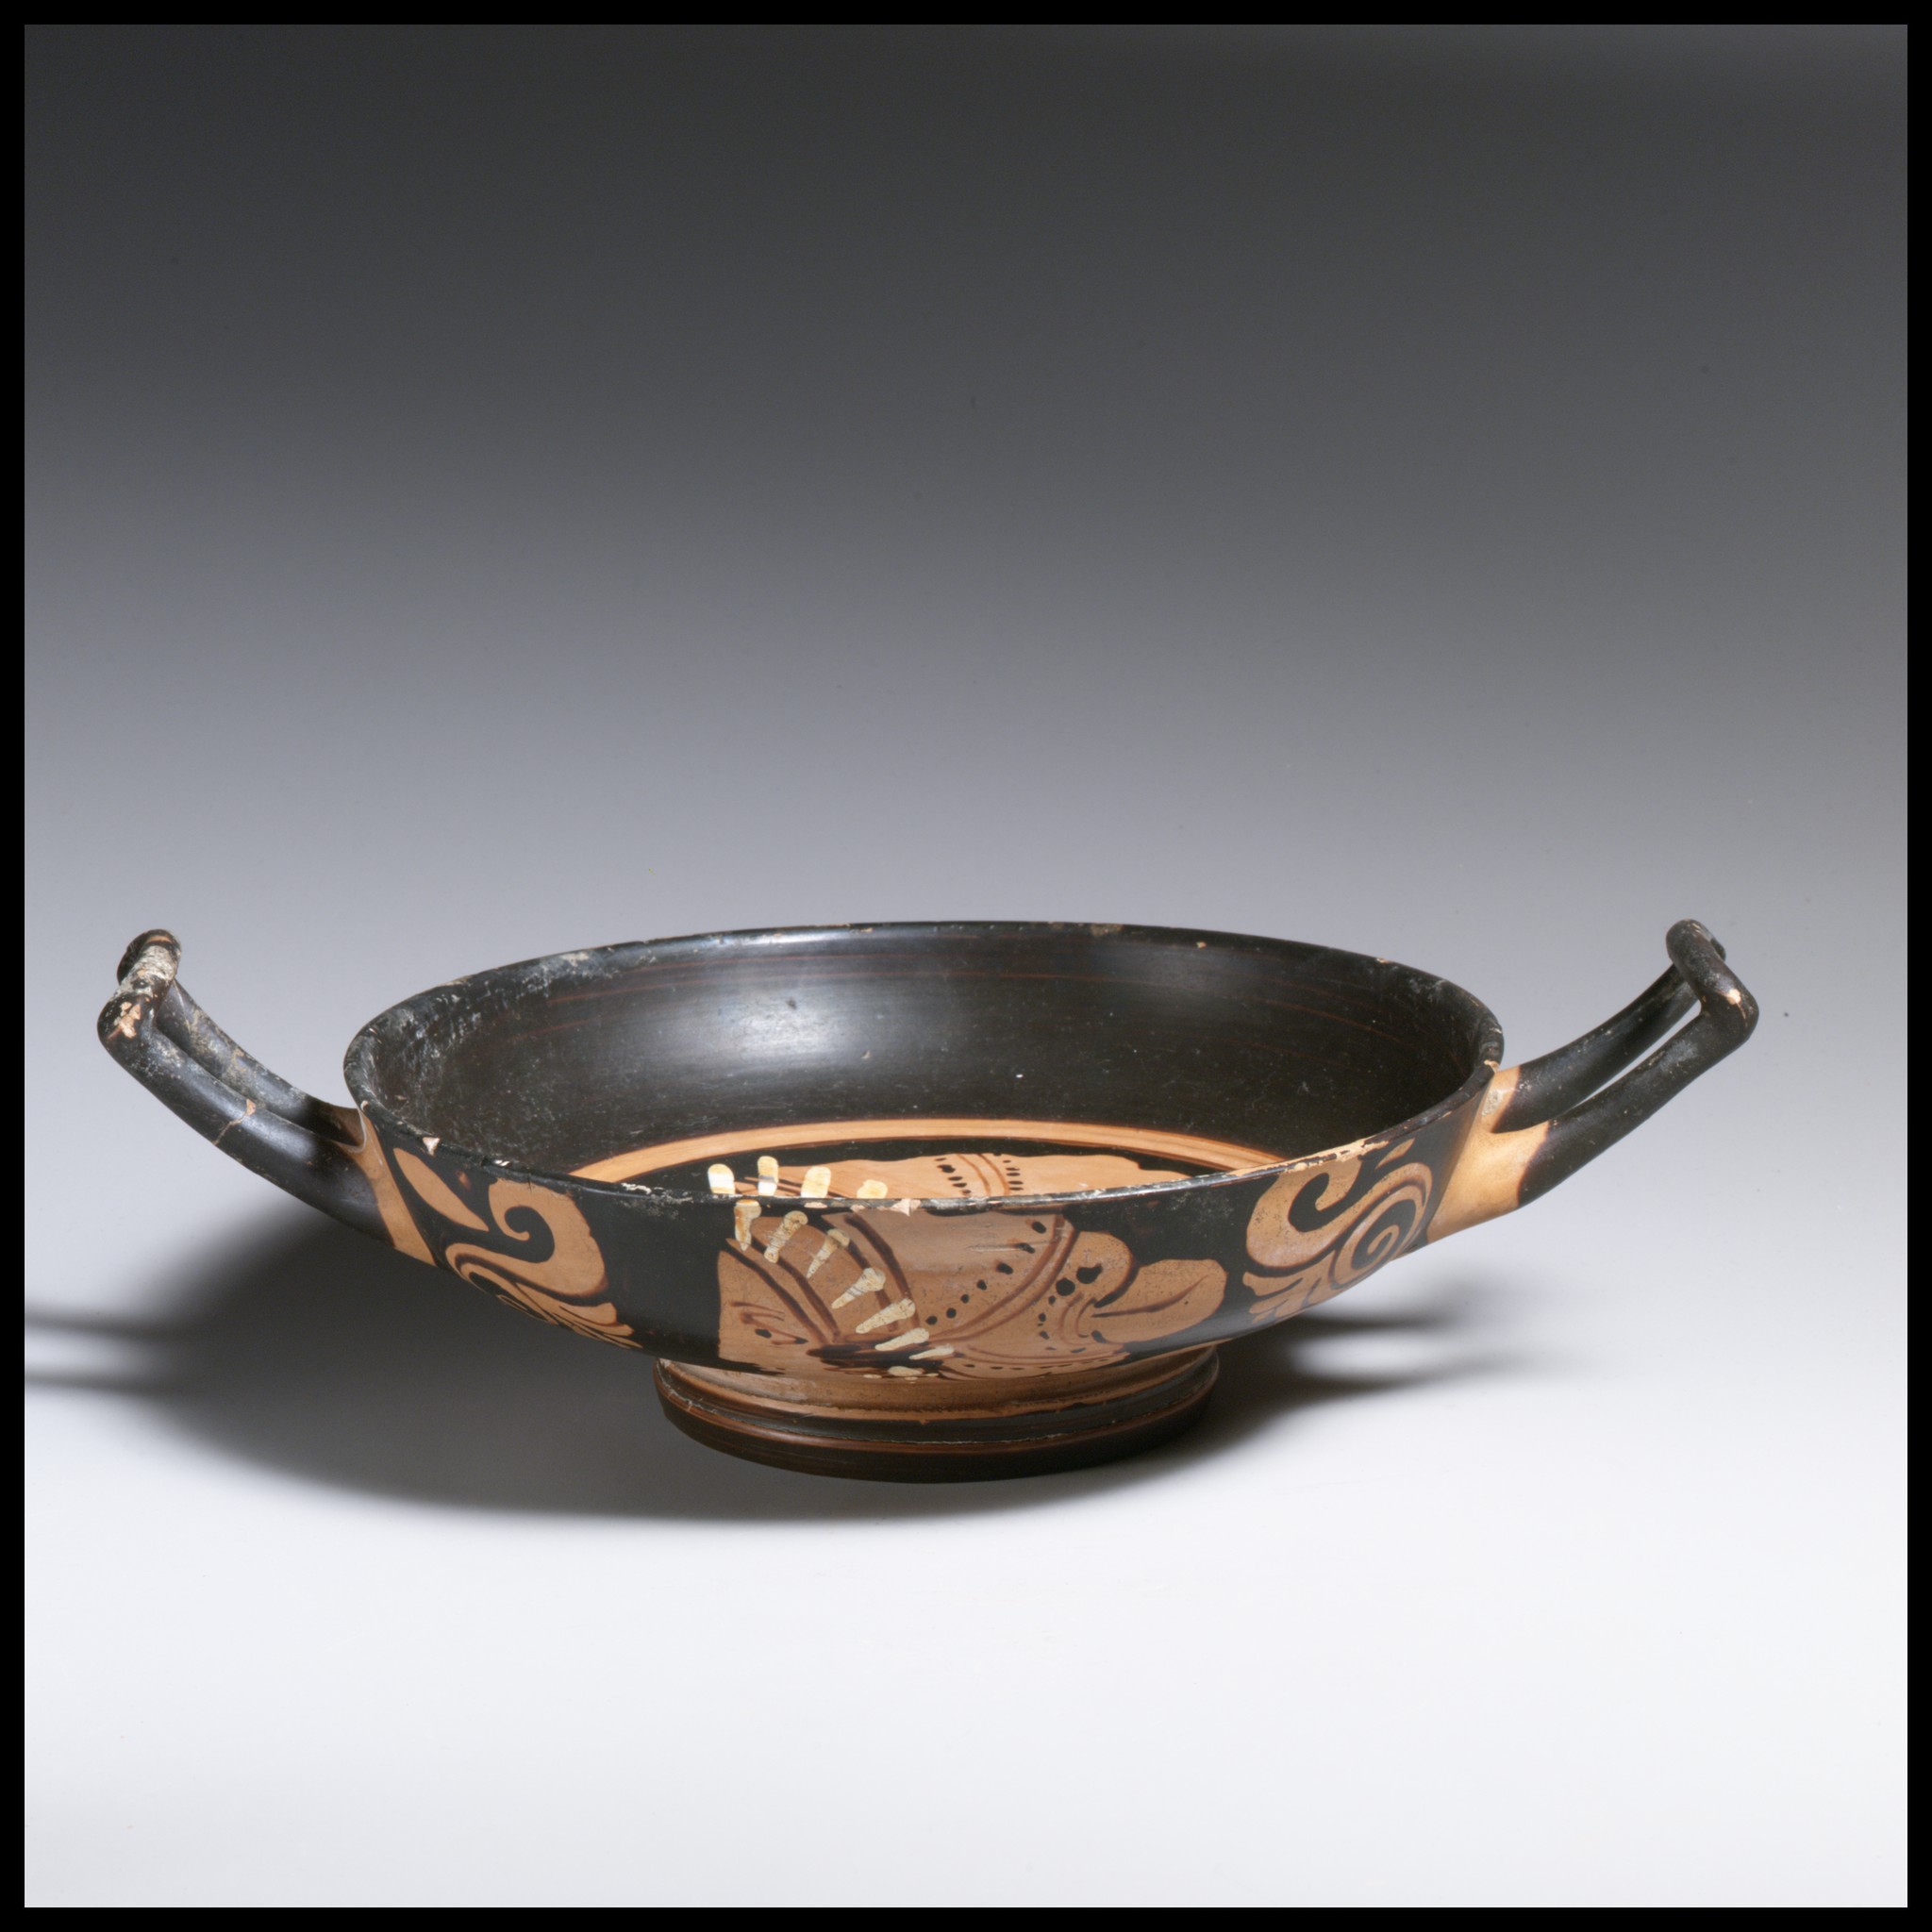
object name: kylix, stemless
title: Terracotta stemless kylix (drinking cup)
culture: greek or south italian or campanian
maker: st. antimo group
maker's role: artist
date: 330-300 BCE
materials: terracotta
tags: diadems,women